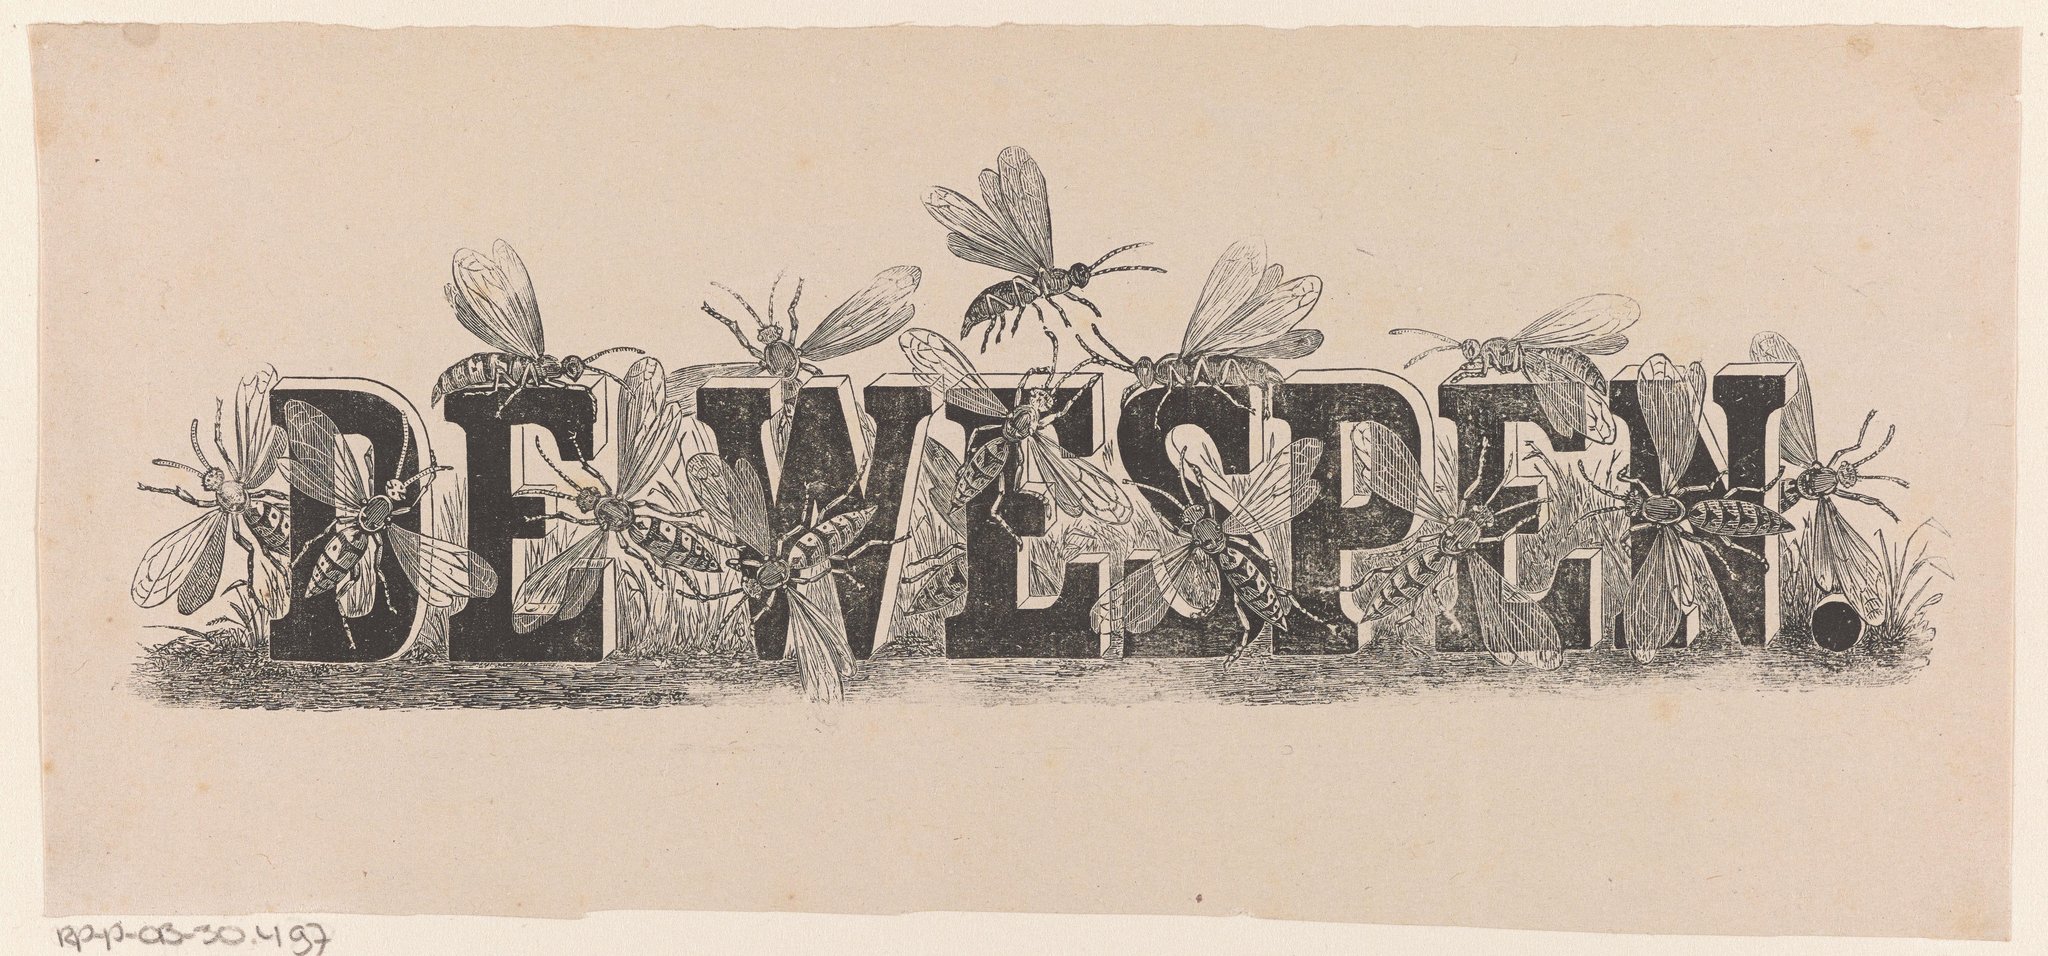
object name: print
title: De wespen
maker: isaac weissenbruch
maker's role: print maker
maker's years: 1826-1912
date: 1836-1912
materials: paper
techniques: engraving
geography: netherlands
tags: insects: wasp